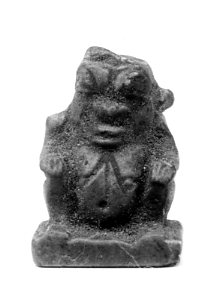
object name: amulet, be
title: Bes amulet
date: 664-332 BCE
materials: faience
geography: egypt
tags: bes